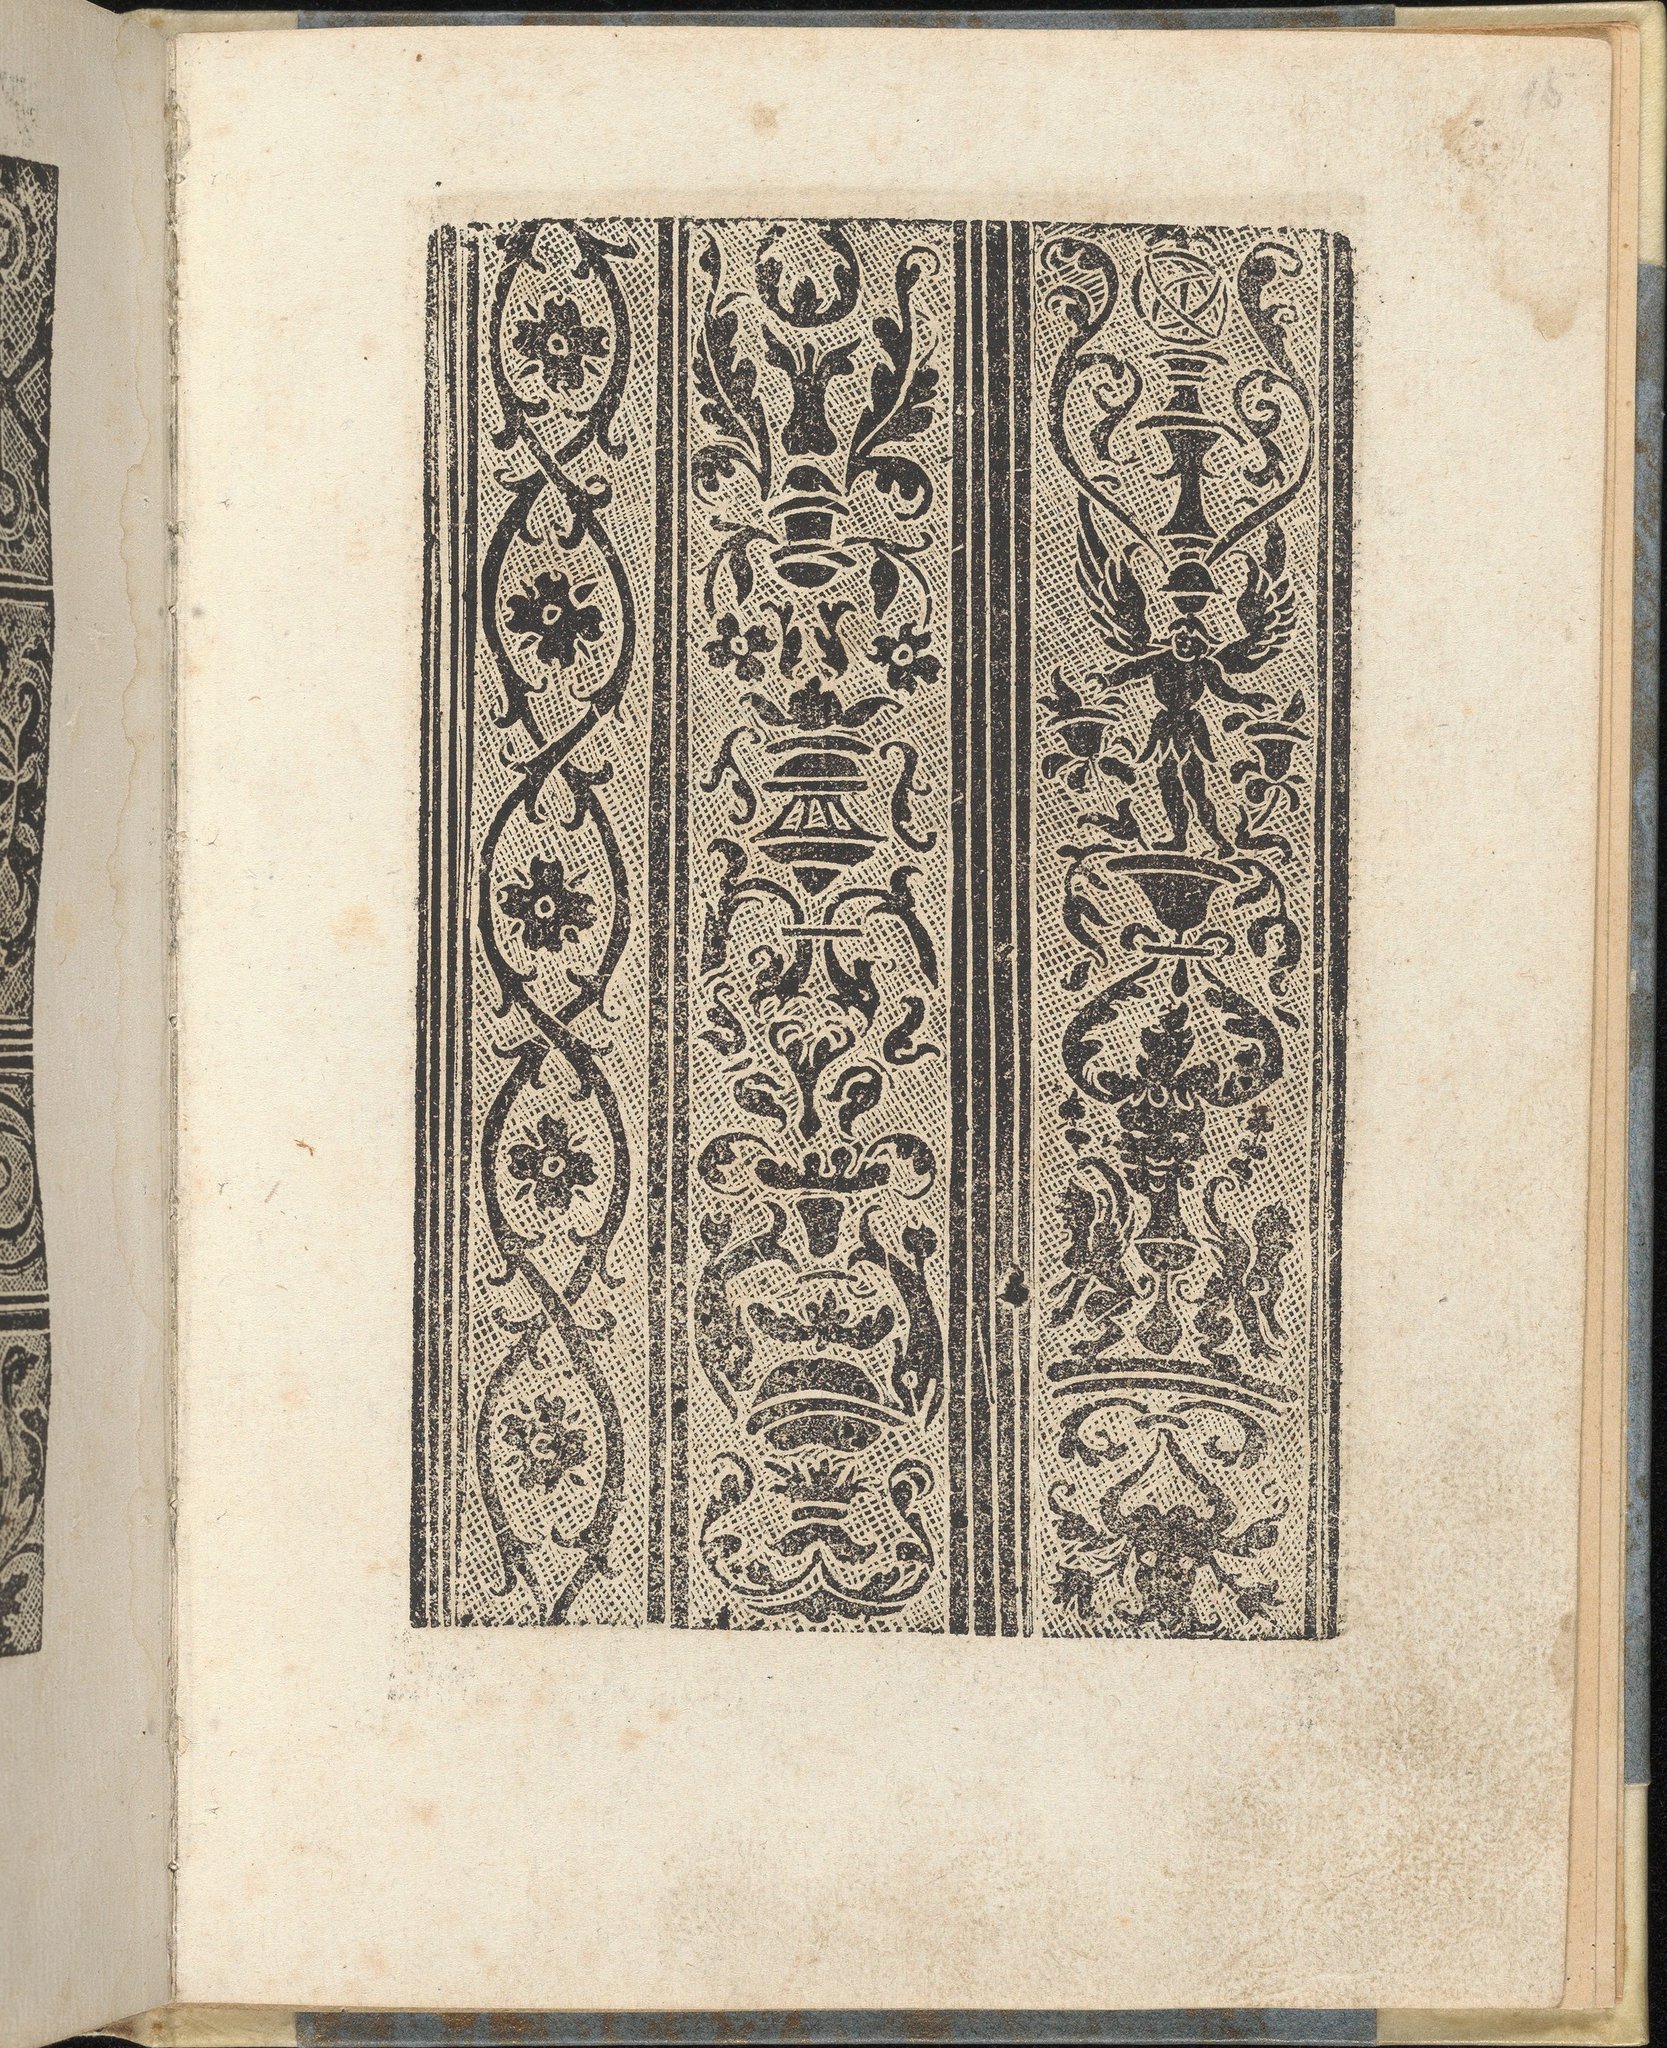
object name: book print ornament architecture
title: Ein ney Furmbüchlein, Page 16, recto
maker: johann schönsperger the younger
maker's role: publisher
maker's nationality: german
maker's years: 1490-1550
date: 1525-1529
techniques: woodcut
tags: flowers